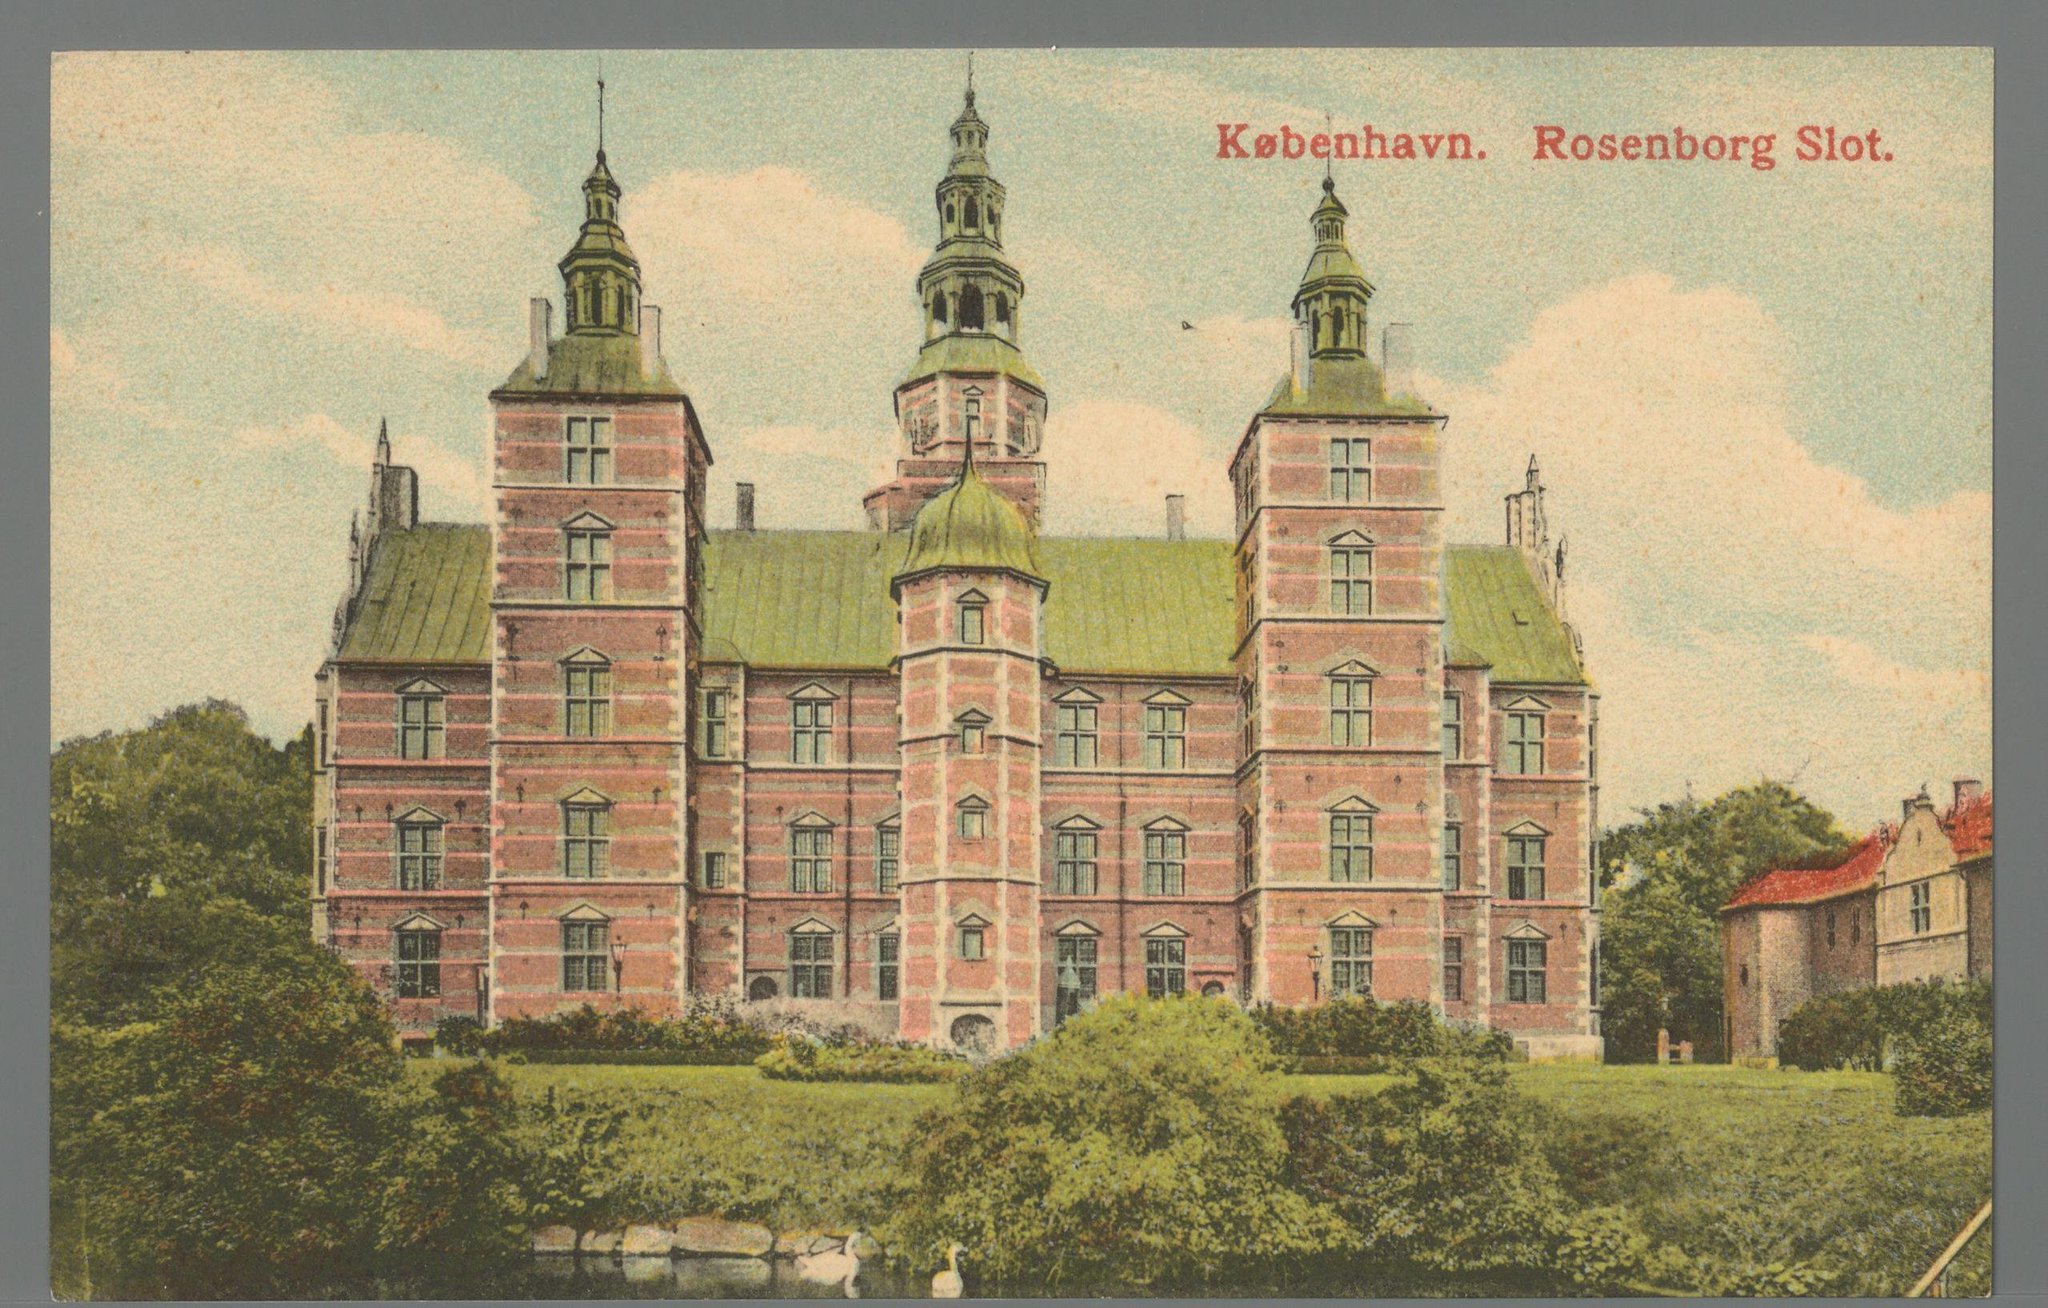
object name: photomechanical print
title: København. Rosenborg Slot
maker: Anonymous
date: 1906-1920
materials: cardboard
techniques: photograph, lithograph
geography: copenhagen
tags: park, palace